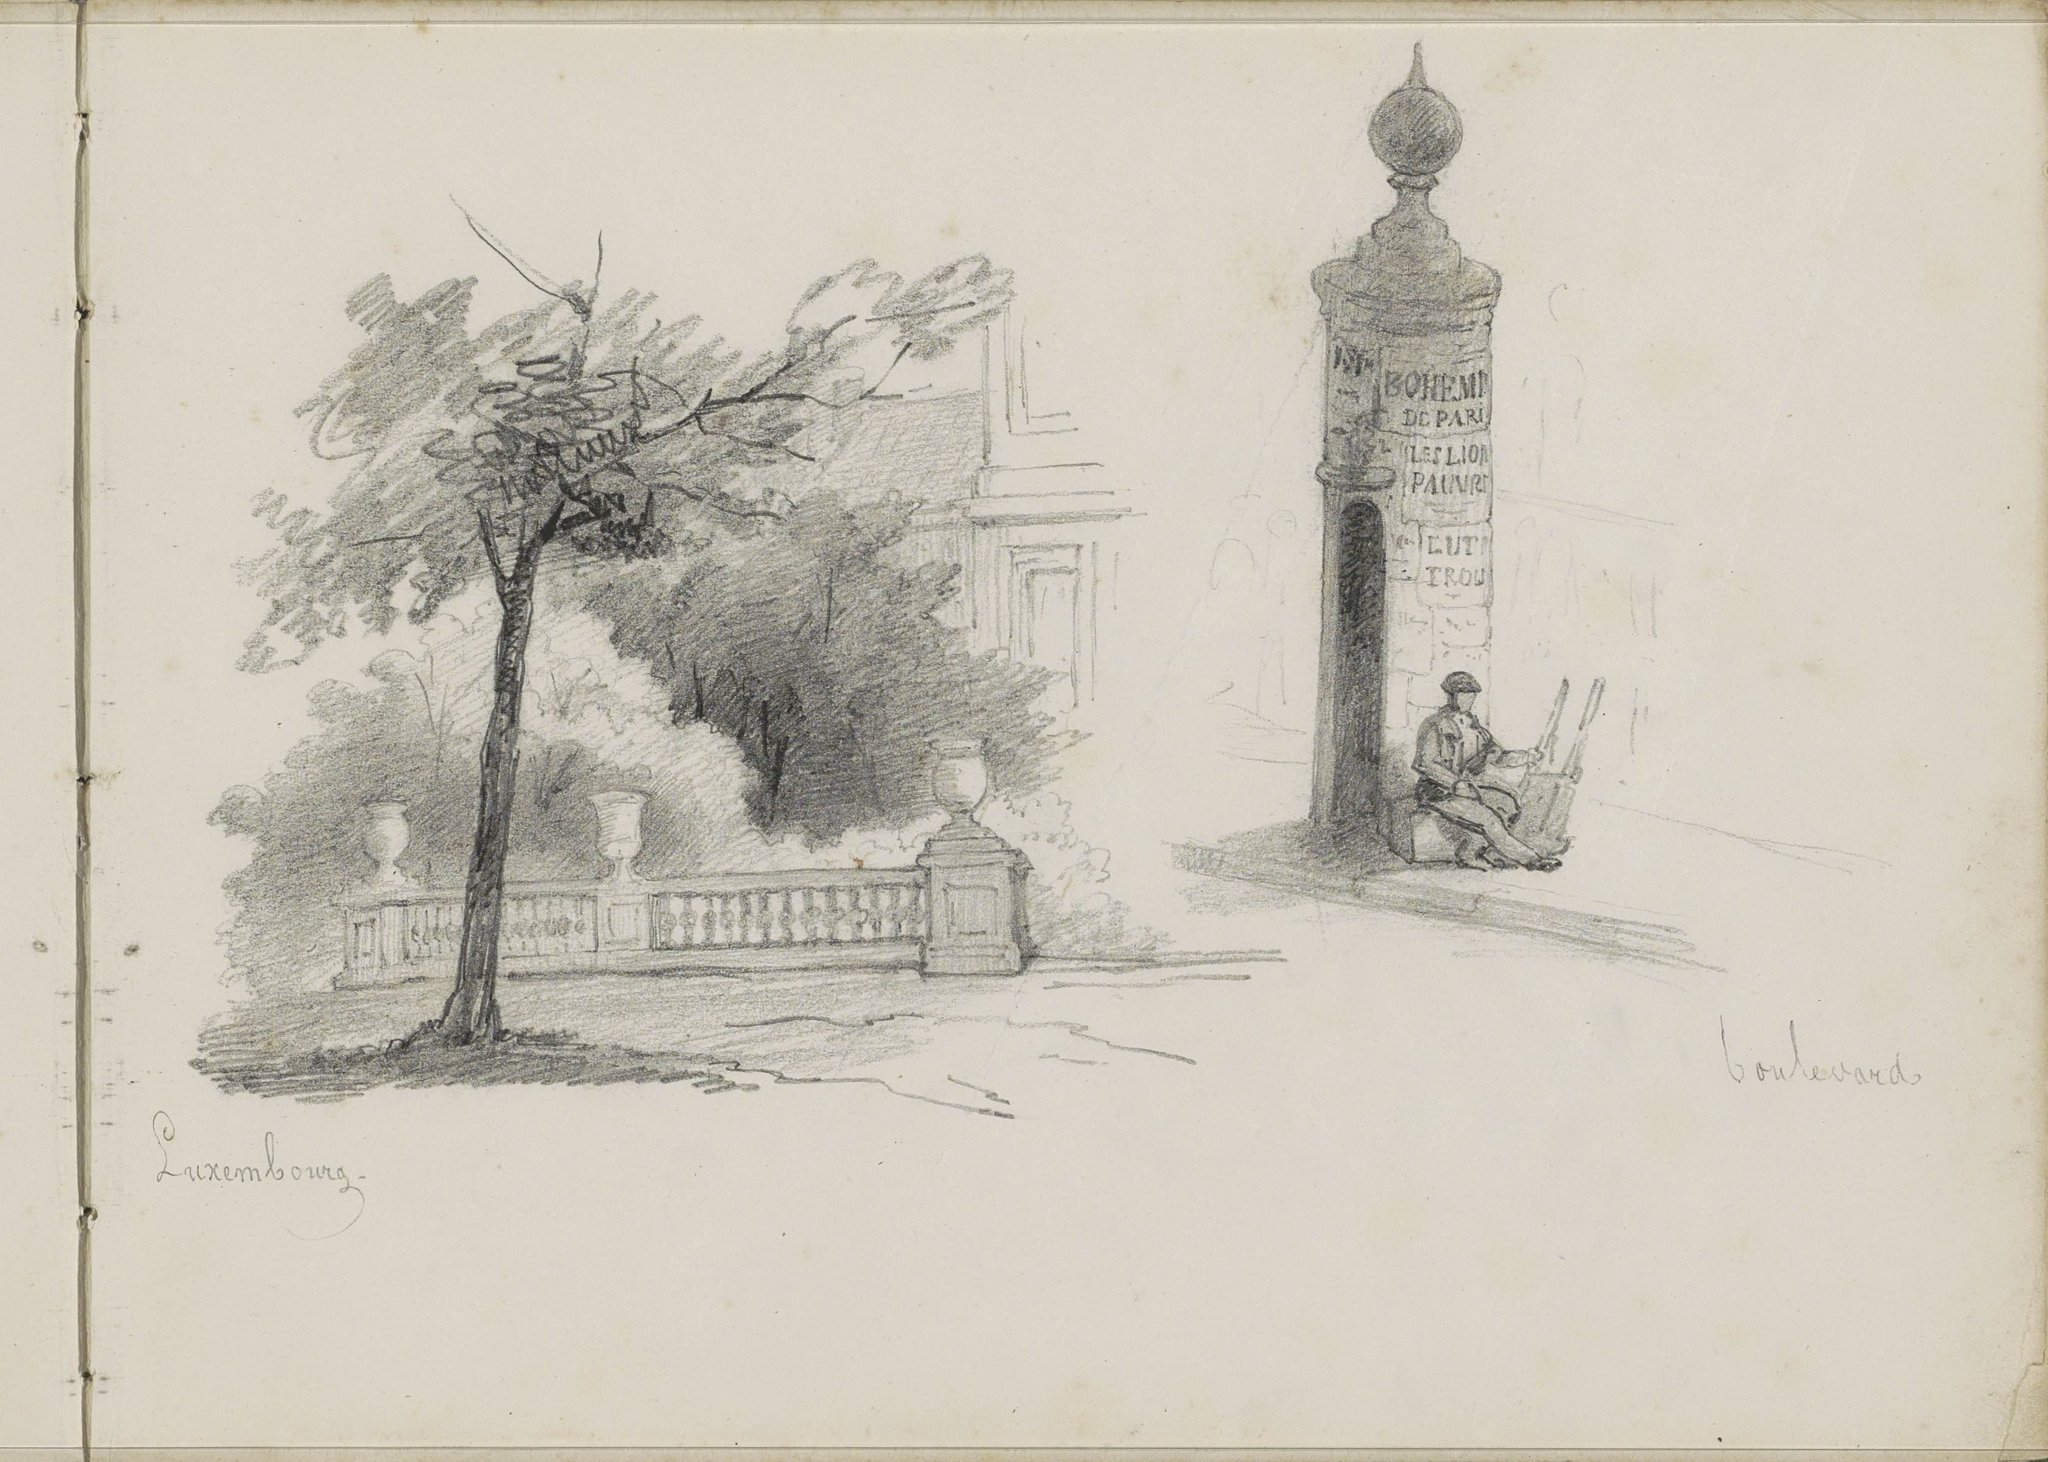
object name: sketchbook leaf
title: Jardin du Luxembourg en man bij een reclamezuil te Parijs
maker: gerrit postma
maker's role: draughtsman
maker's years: 1819-1894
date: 1858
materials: paper, pencil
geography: paris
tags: park, poster-pillar, paris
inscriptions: annotation: ‘Luxembourg./ boulevard’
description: Blad 2 recto uit een schetsboek met 52 bladen.